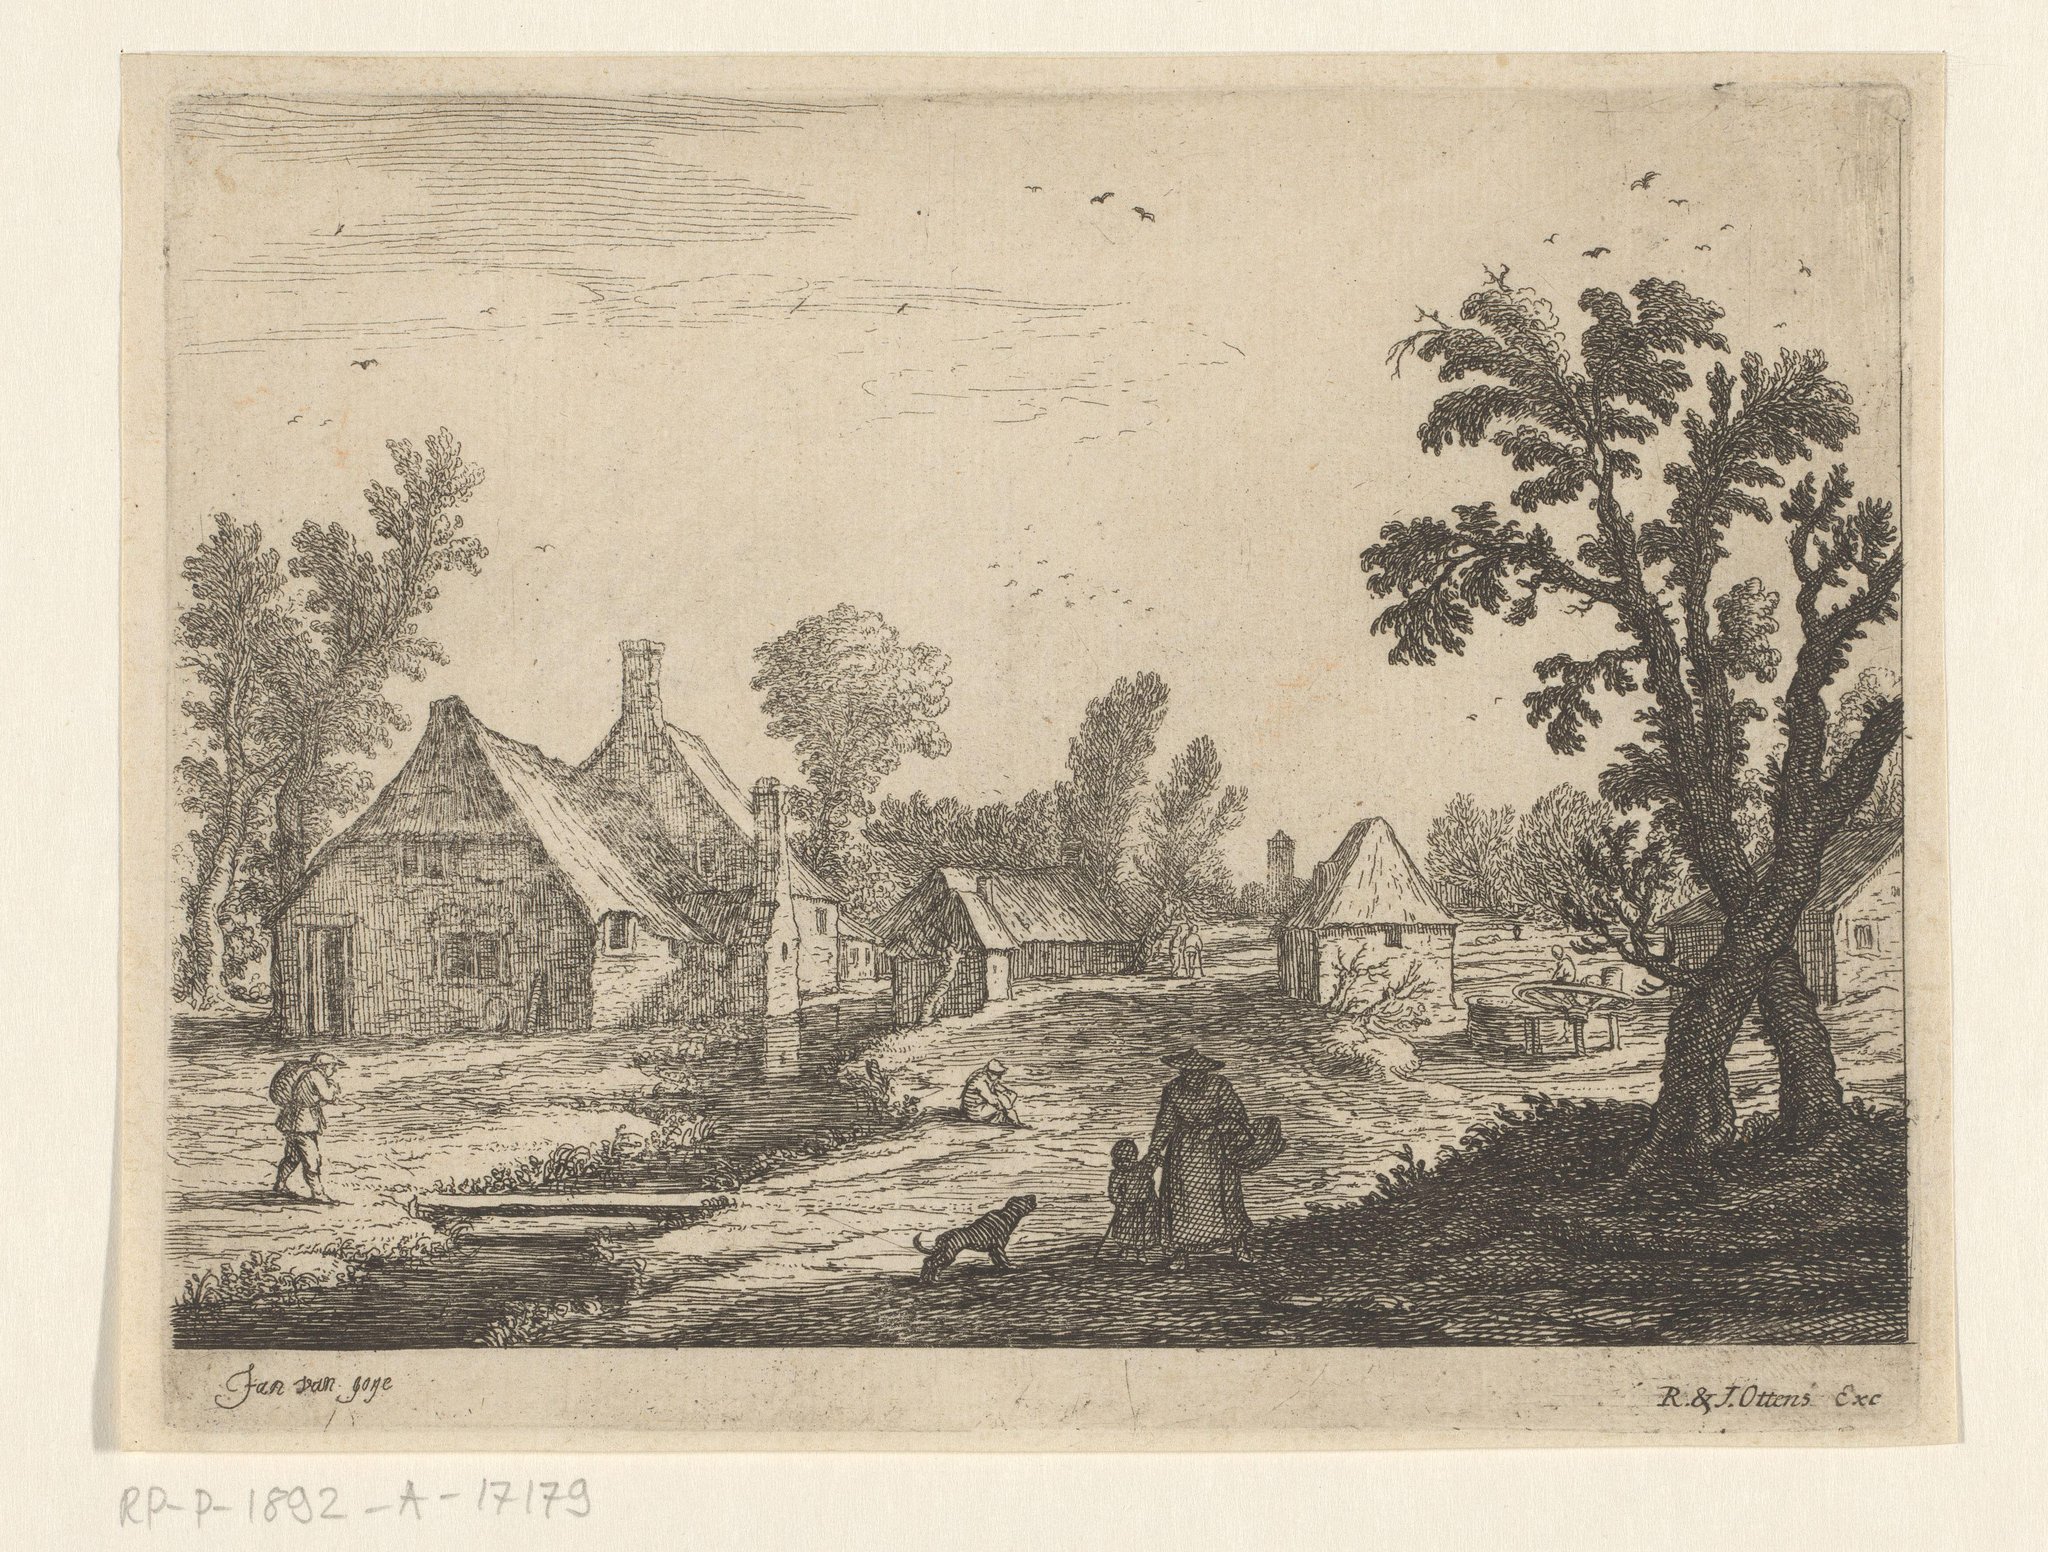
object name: print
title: Dorpsgezicht met vrouw en kind in de dorpsstraat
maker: jan van de cappelle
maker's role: draughtsman, print maker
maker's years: 1624-1679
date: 1640-1679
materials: paper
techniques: etching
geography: amsterdam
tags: landscapes, public road in village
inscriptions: collector's mark: Lugt 2228